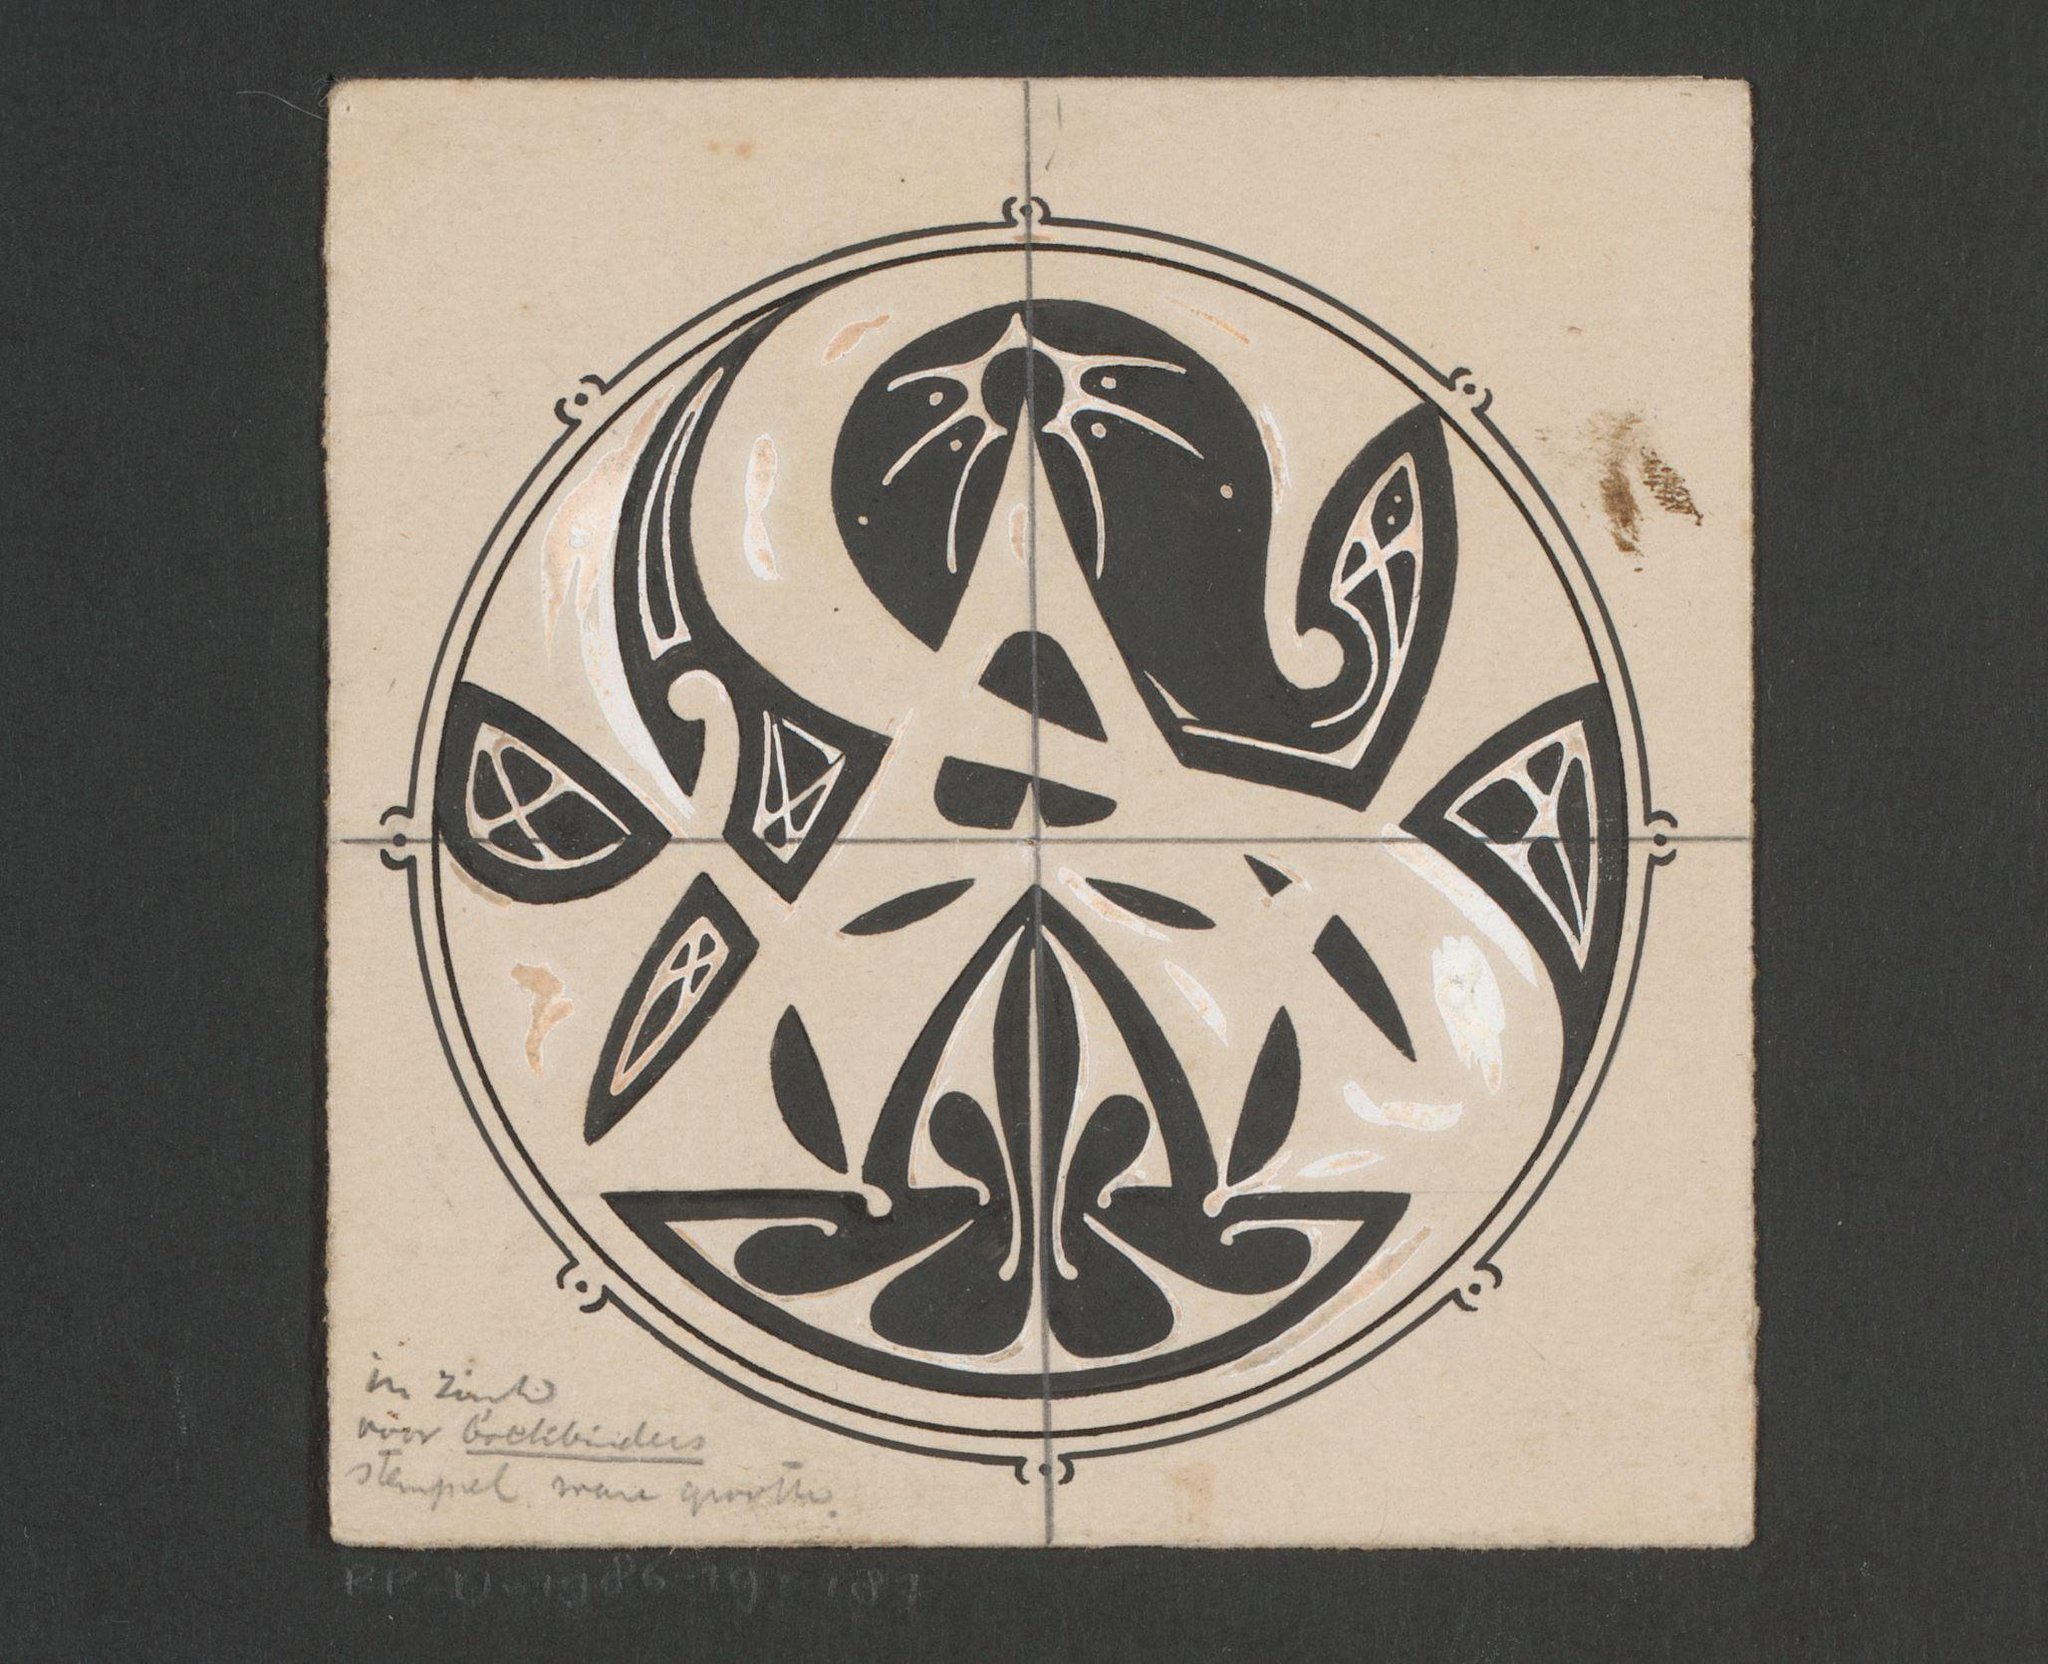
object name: design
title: Ontwerp voor een vignet met monogram AWS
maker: reinier willem petrus de vries (1874-1953)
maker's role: draughtsman, print maker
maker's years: 1874-1953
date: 1901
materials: paint, ink, paper, pencil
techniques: brush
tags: leiden, albertus willem sijthoff, magic mathematical figures; magic numbers, words, monograms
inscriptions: annotation: ‘in zink/ voor boekbinders/ stempel ware grootte’, number: ‘n 5093/ N 3002.’, collector's mark: ‘R:MVS.’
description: De boekbindersstempel waarvoor dit ontwerp is bedoeld zou gebruikt worden voor de band van een album voor A.W. Sijthoff ter gelegenheid van diens vijftigjarige uitgeversloopbaan.